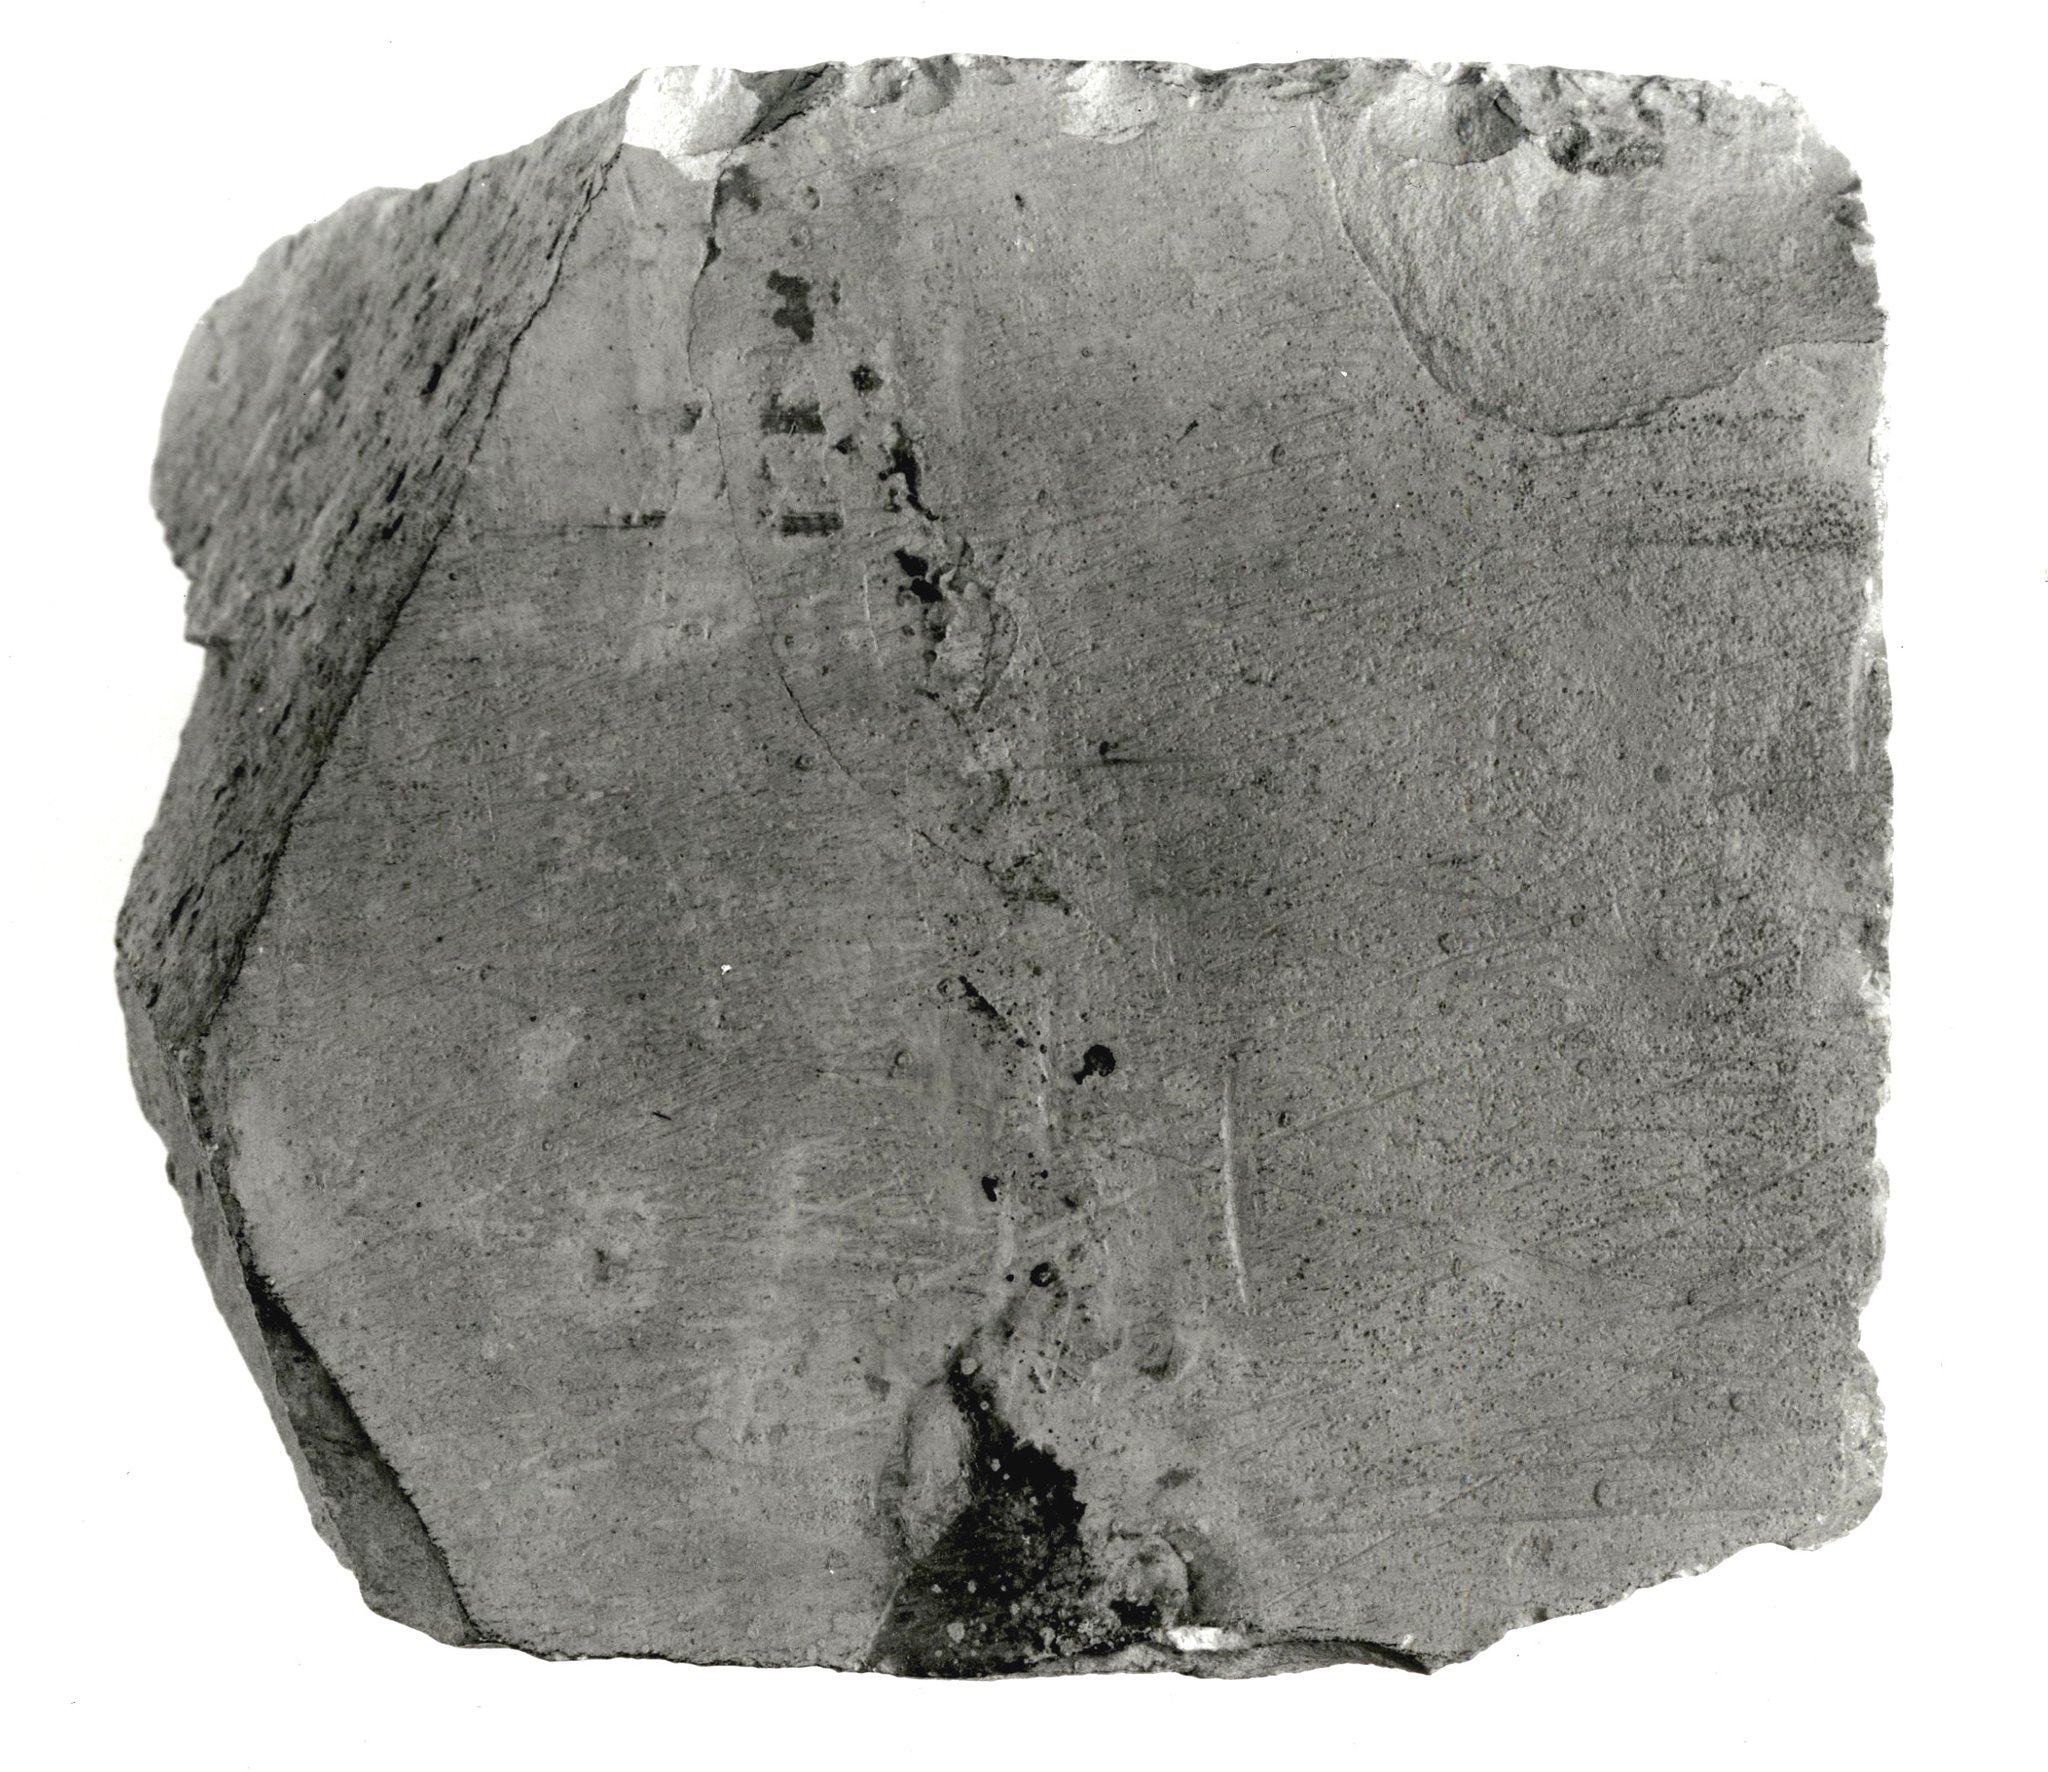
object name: relief, tomb of nespekashuty, wall casing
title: Wall casing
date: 664-610 BCE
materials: limestone, varnish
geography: egypt